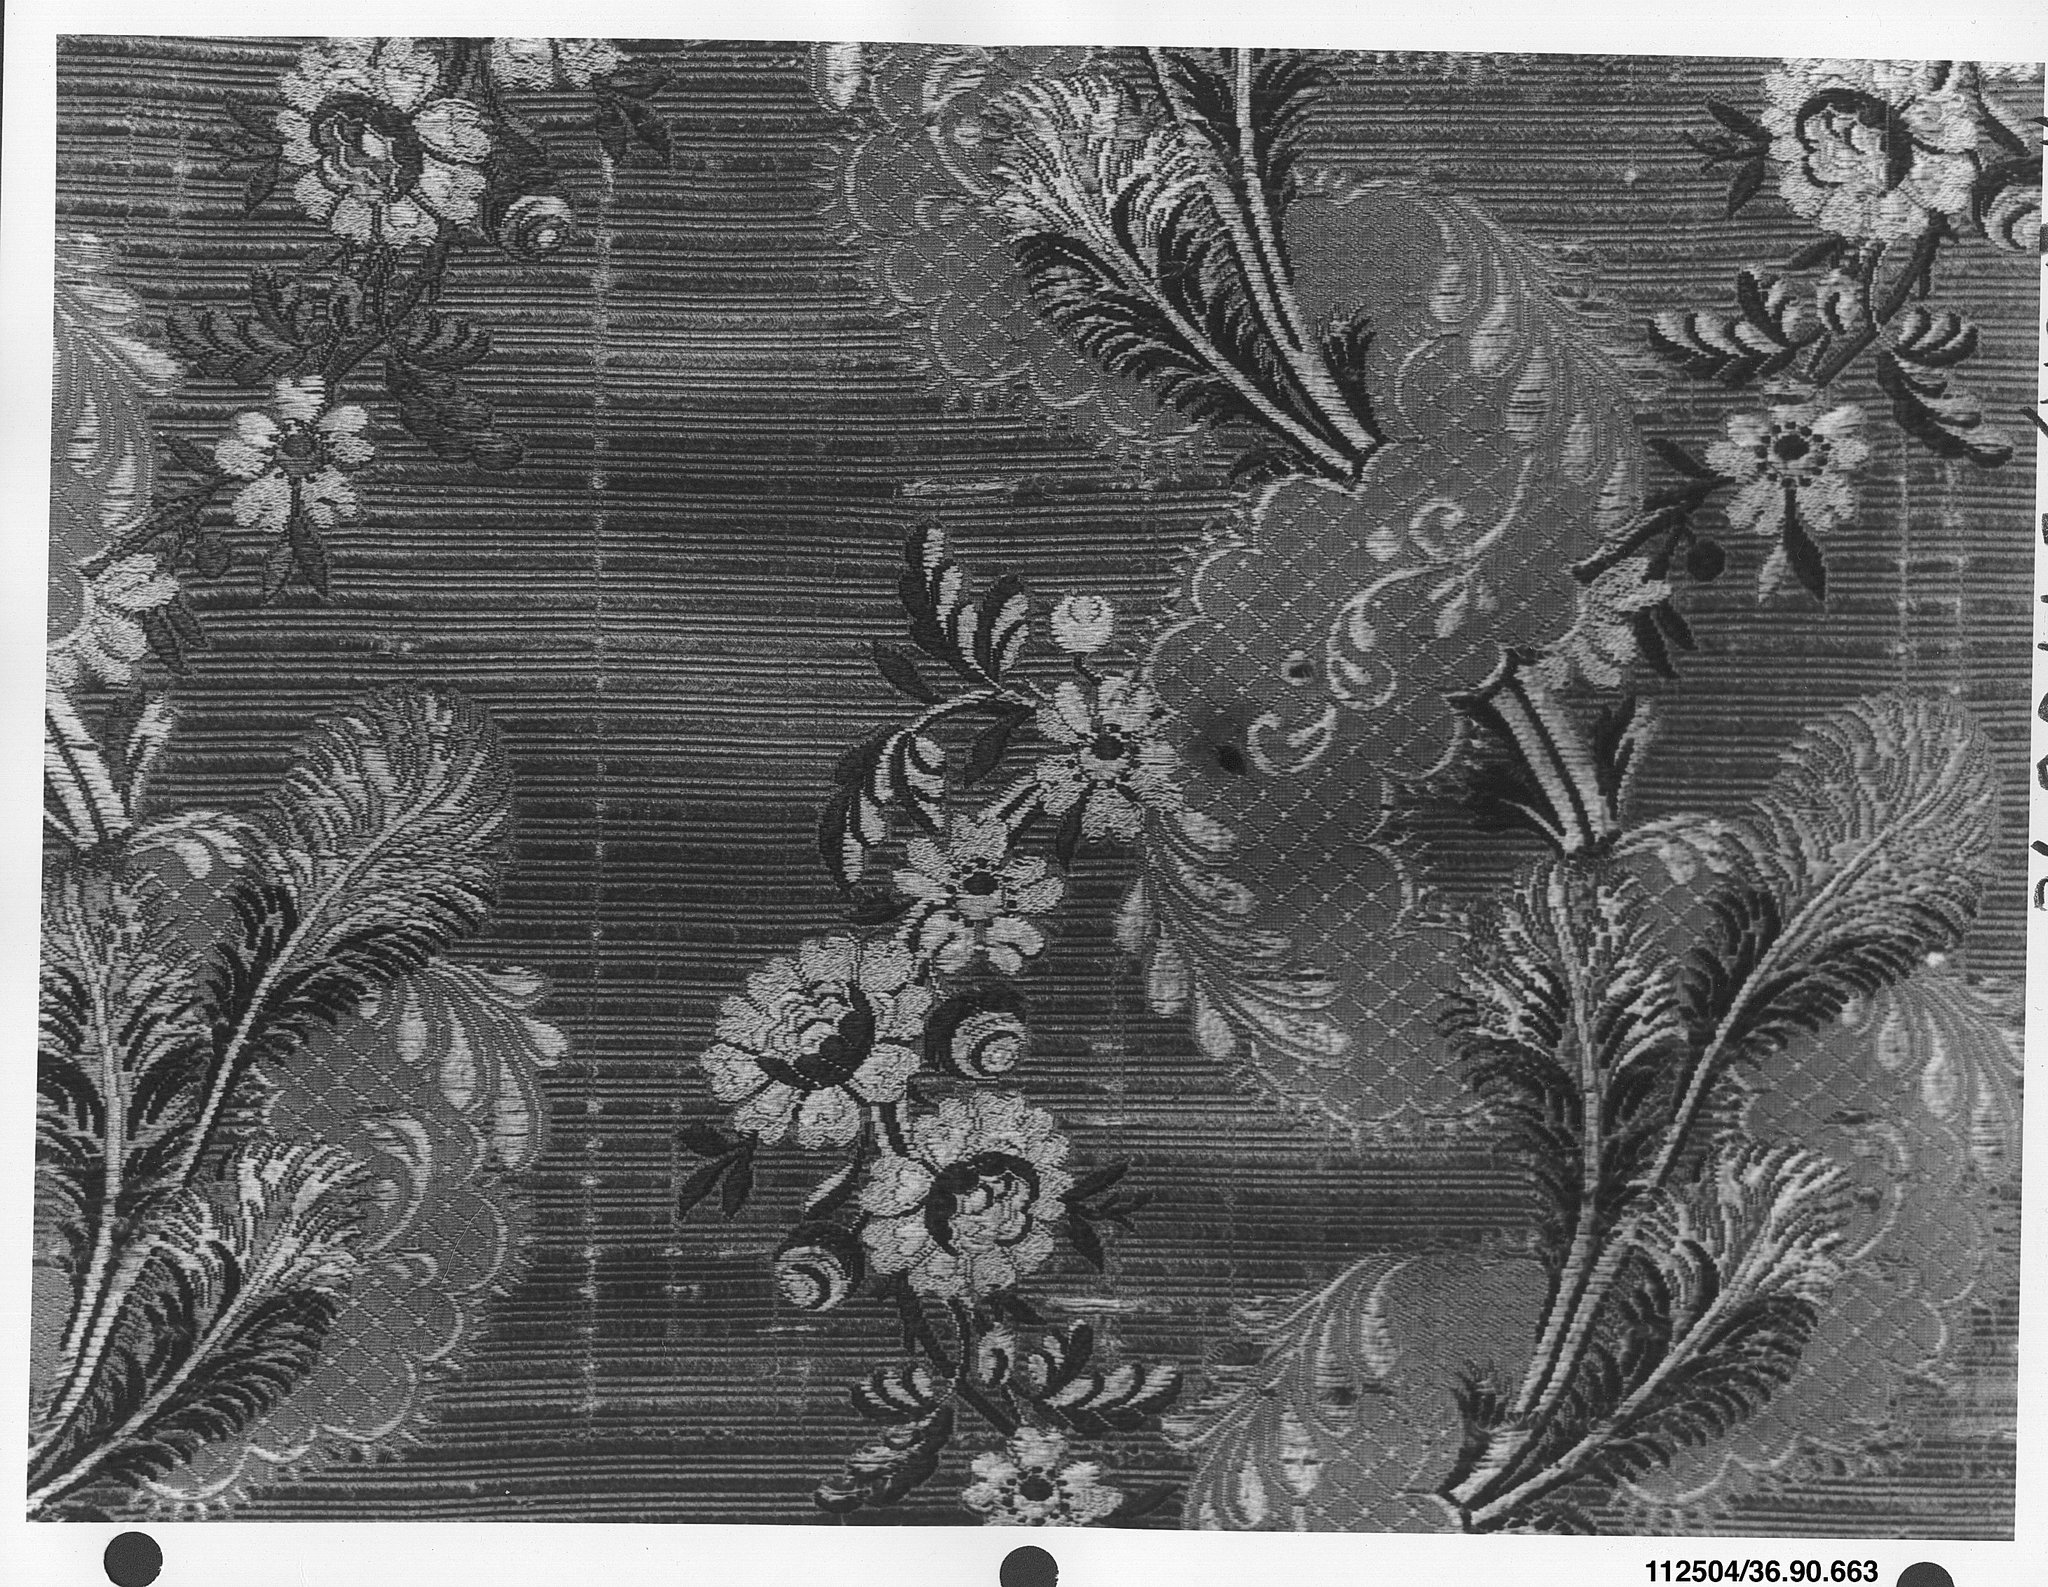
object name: piece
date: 1750-1760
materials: silk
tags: flowers,leaves